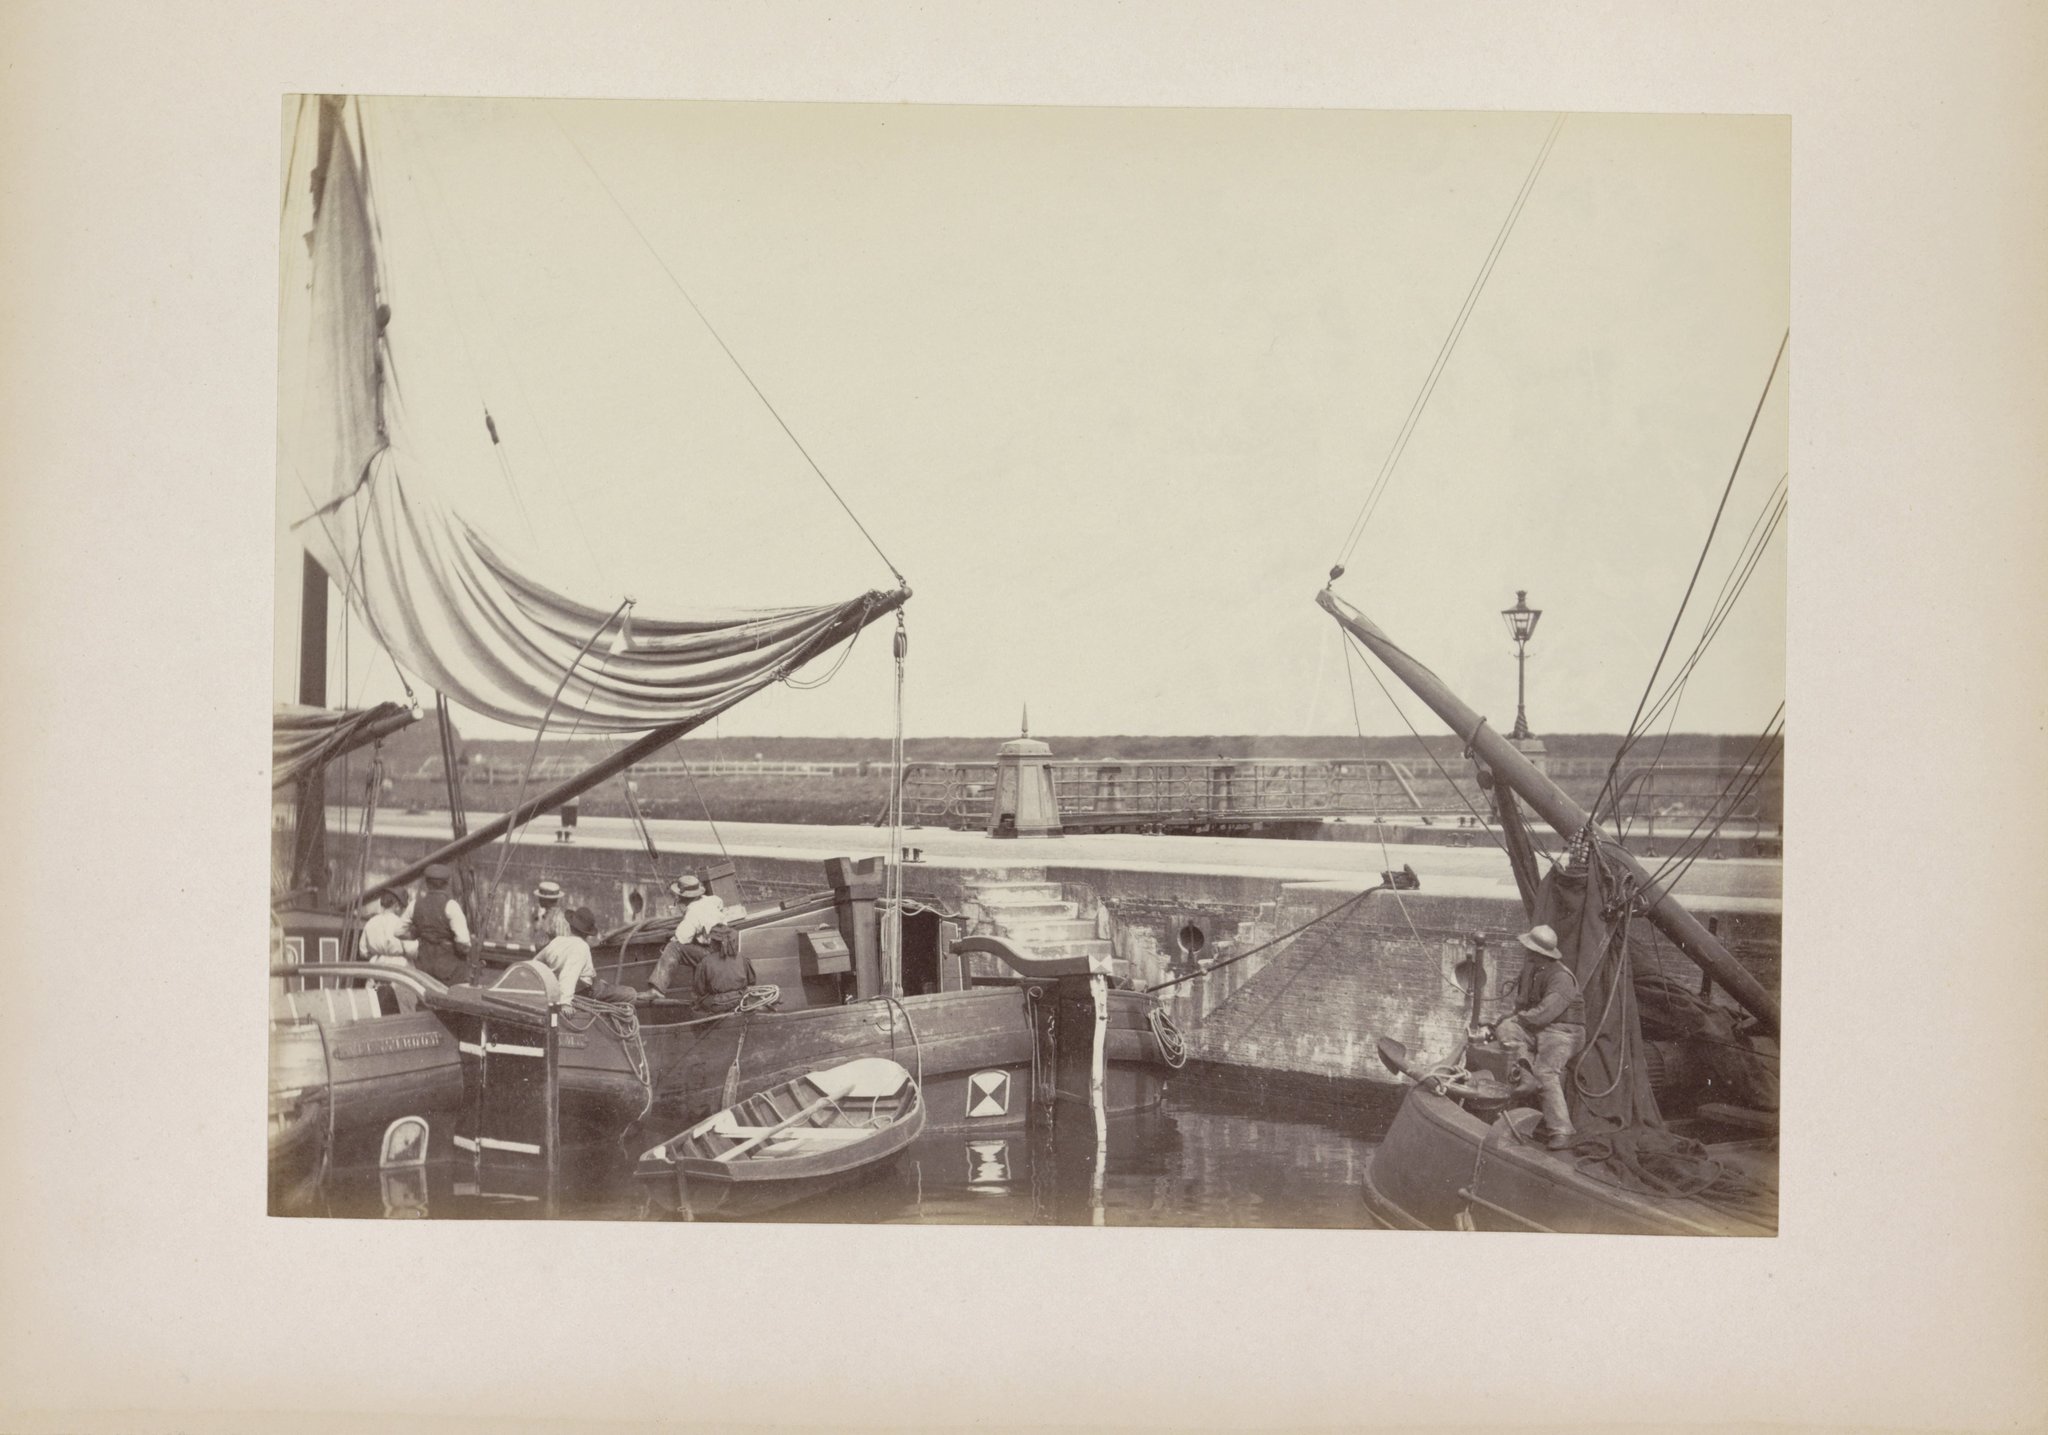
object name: photograph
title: Drie schepen in een sluis in Amsterdam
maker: Anonymous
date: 1885-1900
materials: paper, photographic support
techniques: albumen print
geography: france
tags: sluice, weir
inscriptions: annotation: ‘Amsterdam’